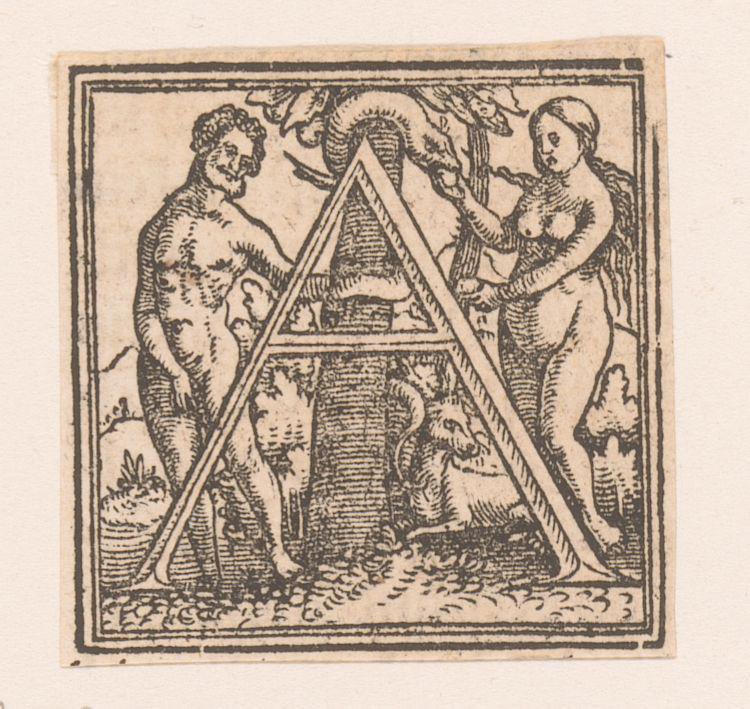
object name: print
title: Versierde initialen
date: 1556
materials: paper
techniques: letterpress printing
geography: zurich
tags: initial, temptation and fall (scenes with both adam and eve)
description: Prent afkomstig uit: Bibel, die gantze, das ist alle Bücher alts und news Testaments (...). Zürich: Johann Froschauer, 1556.